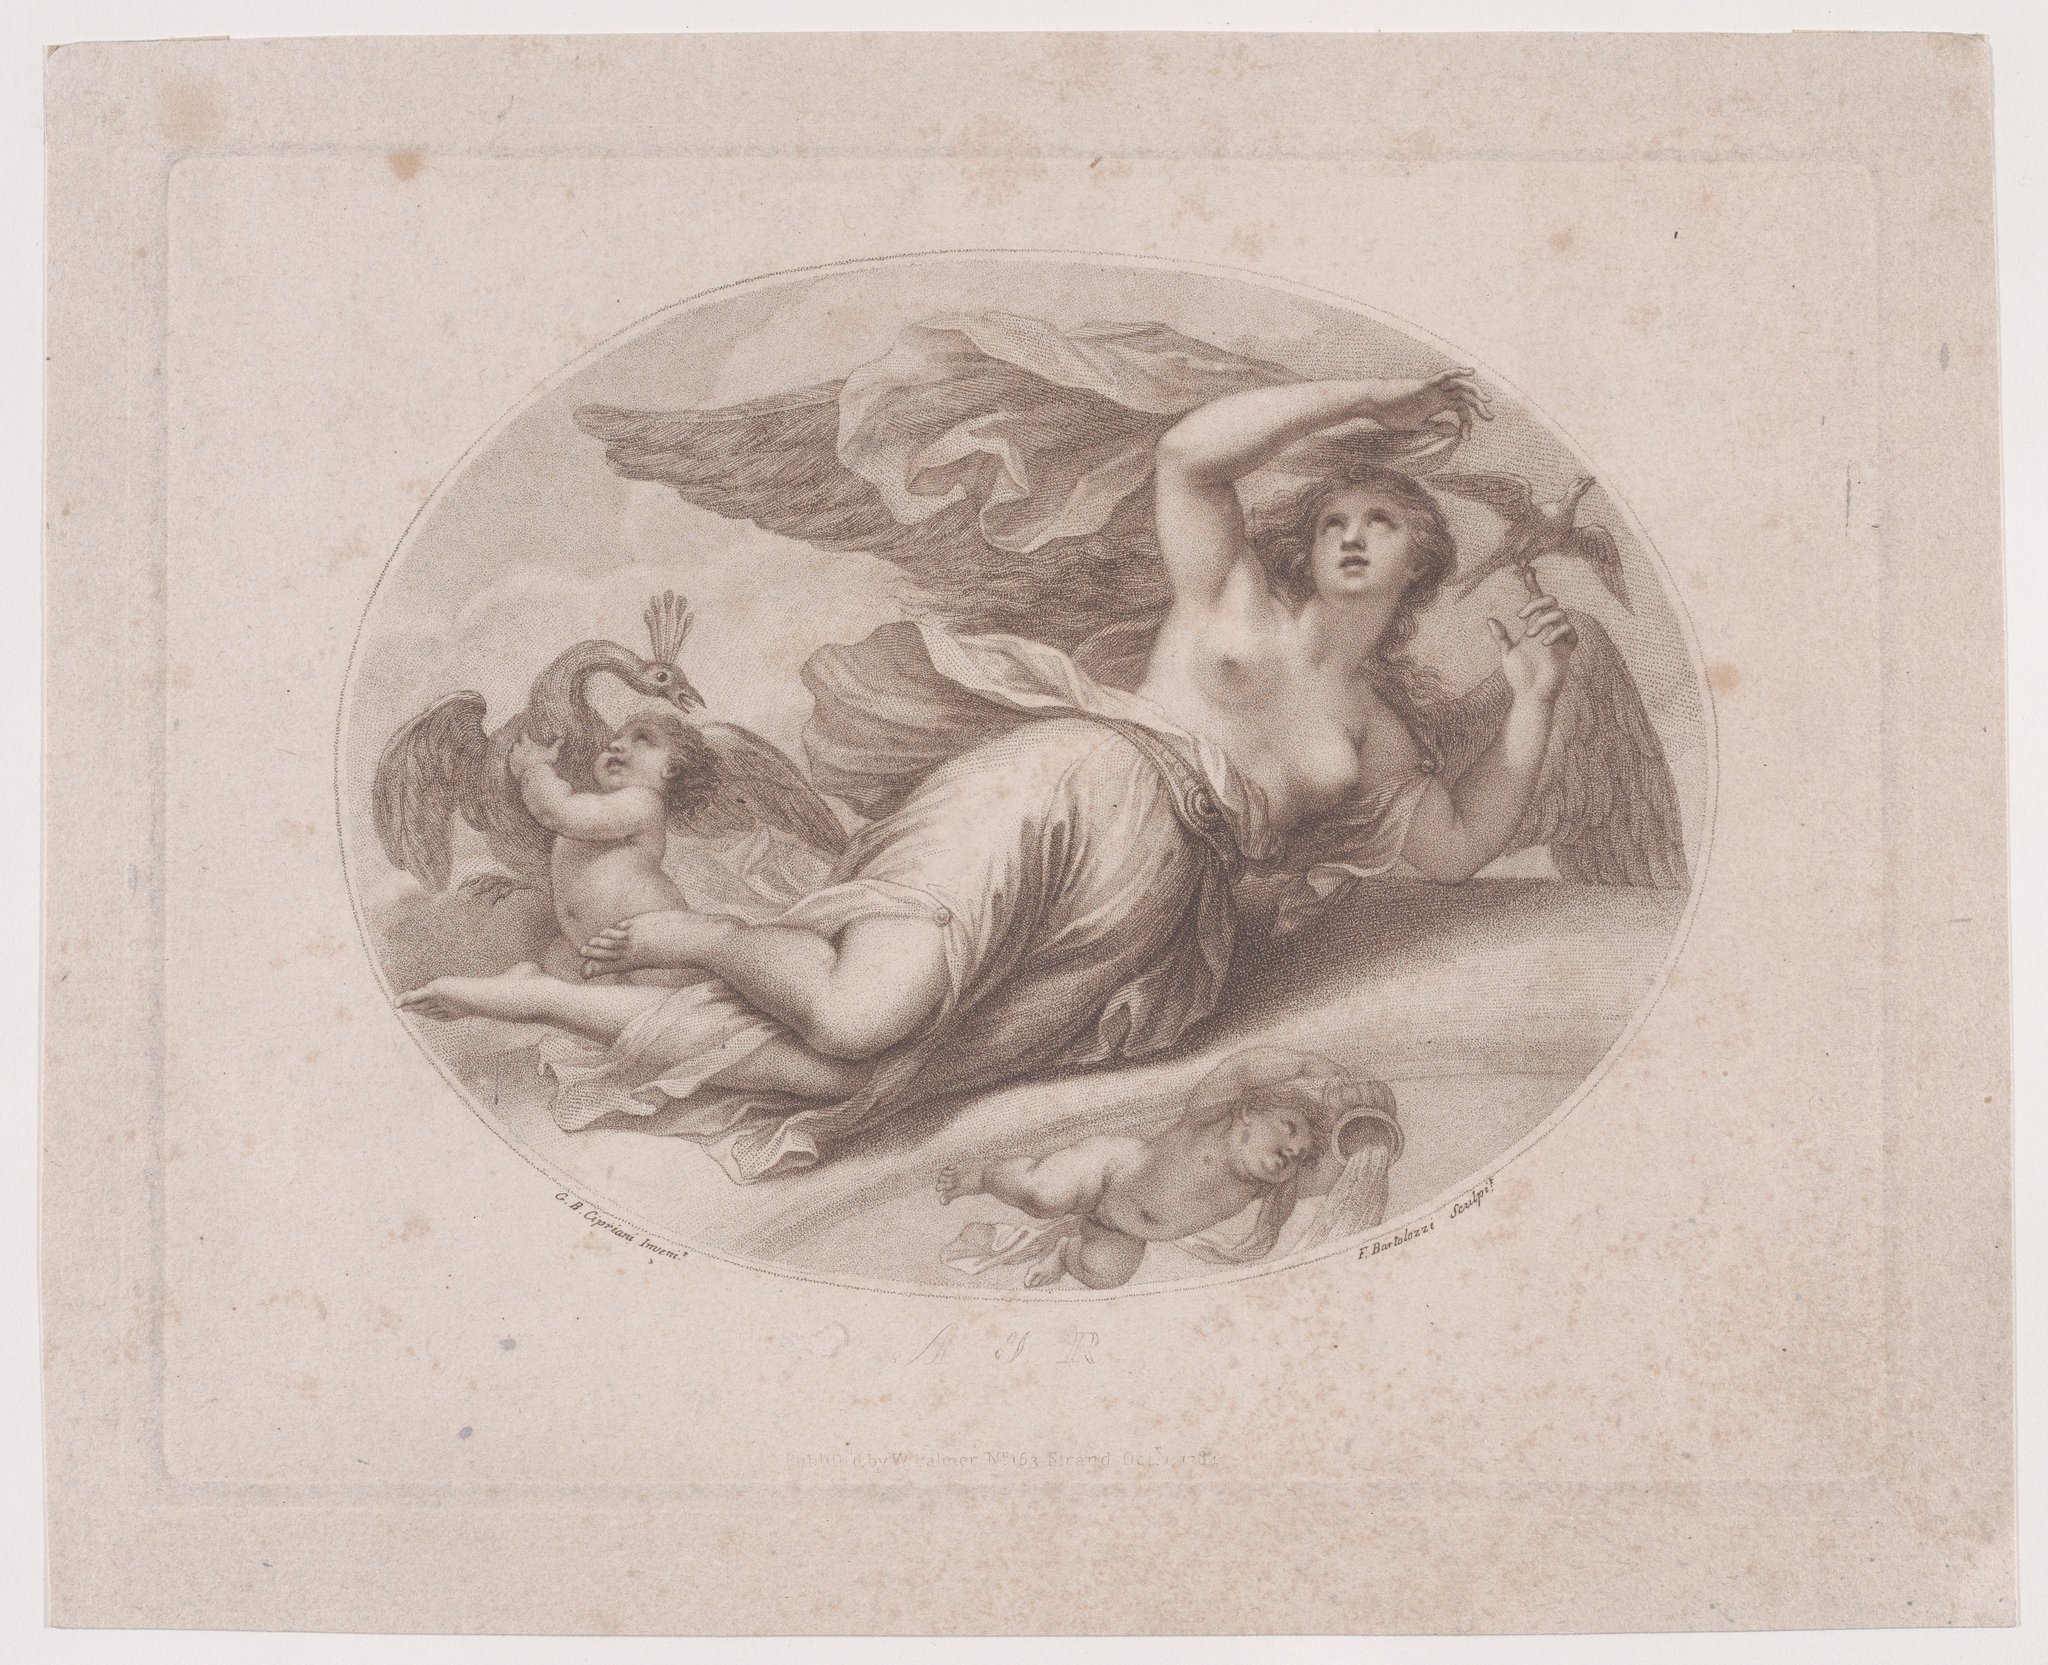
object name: print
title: Air, from "The Four Elements"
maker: francesco bartolozzi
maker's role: artist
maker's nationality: italian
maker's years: 1728-1815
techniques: engraving, etching, printing